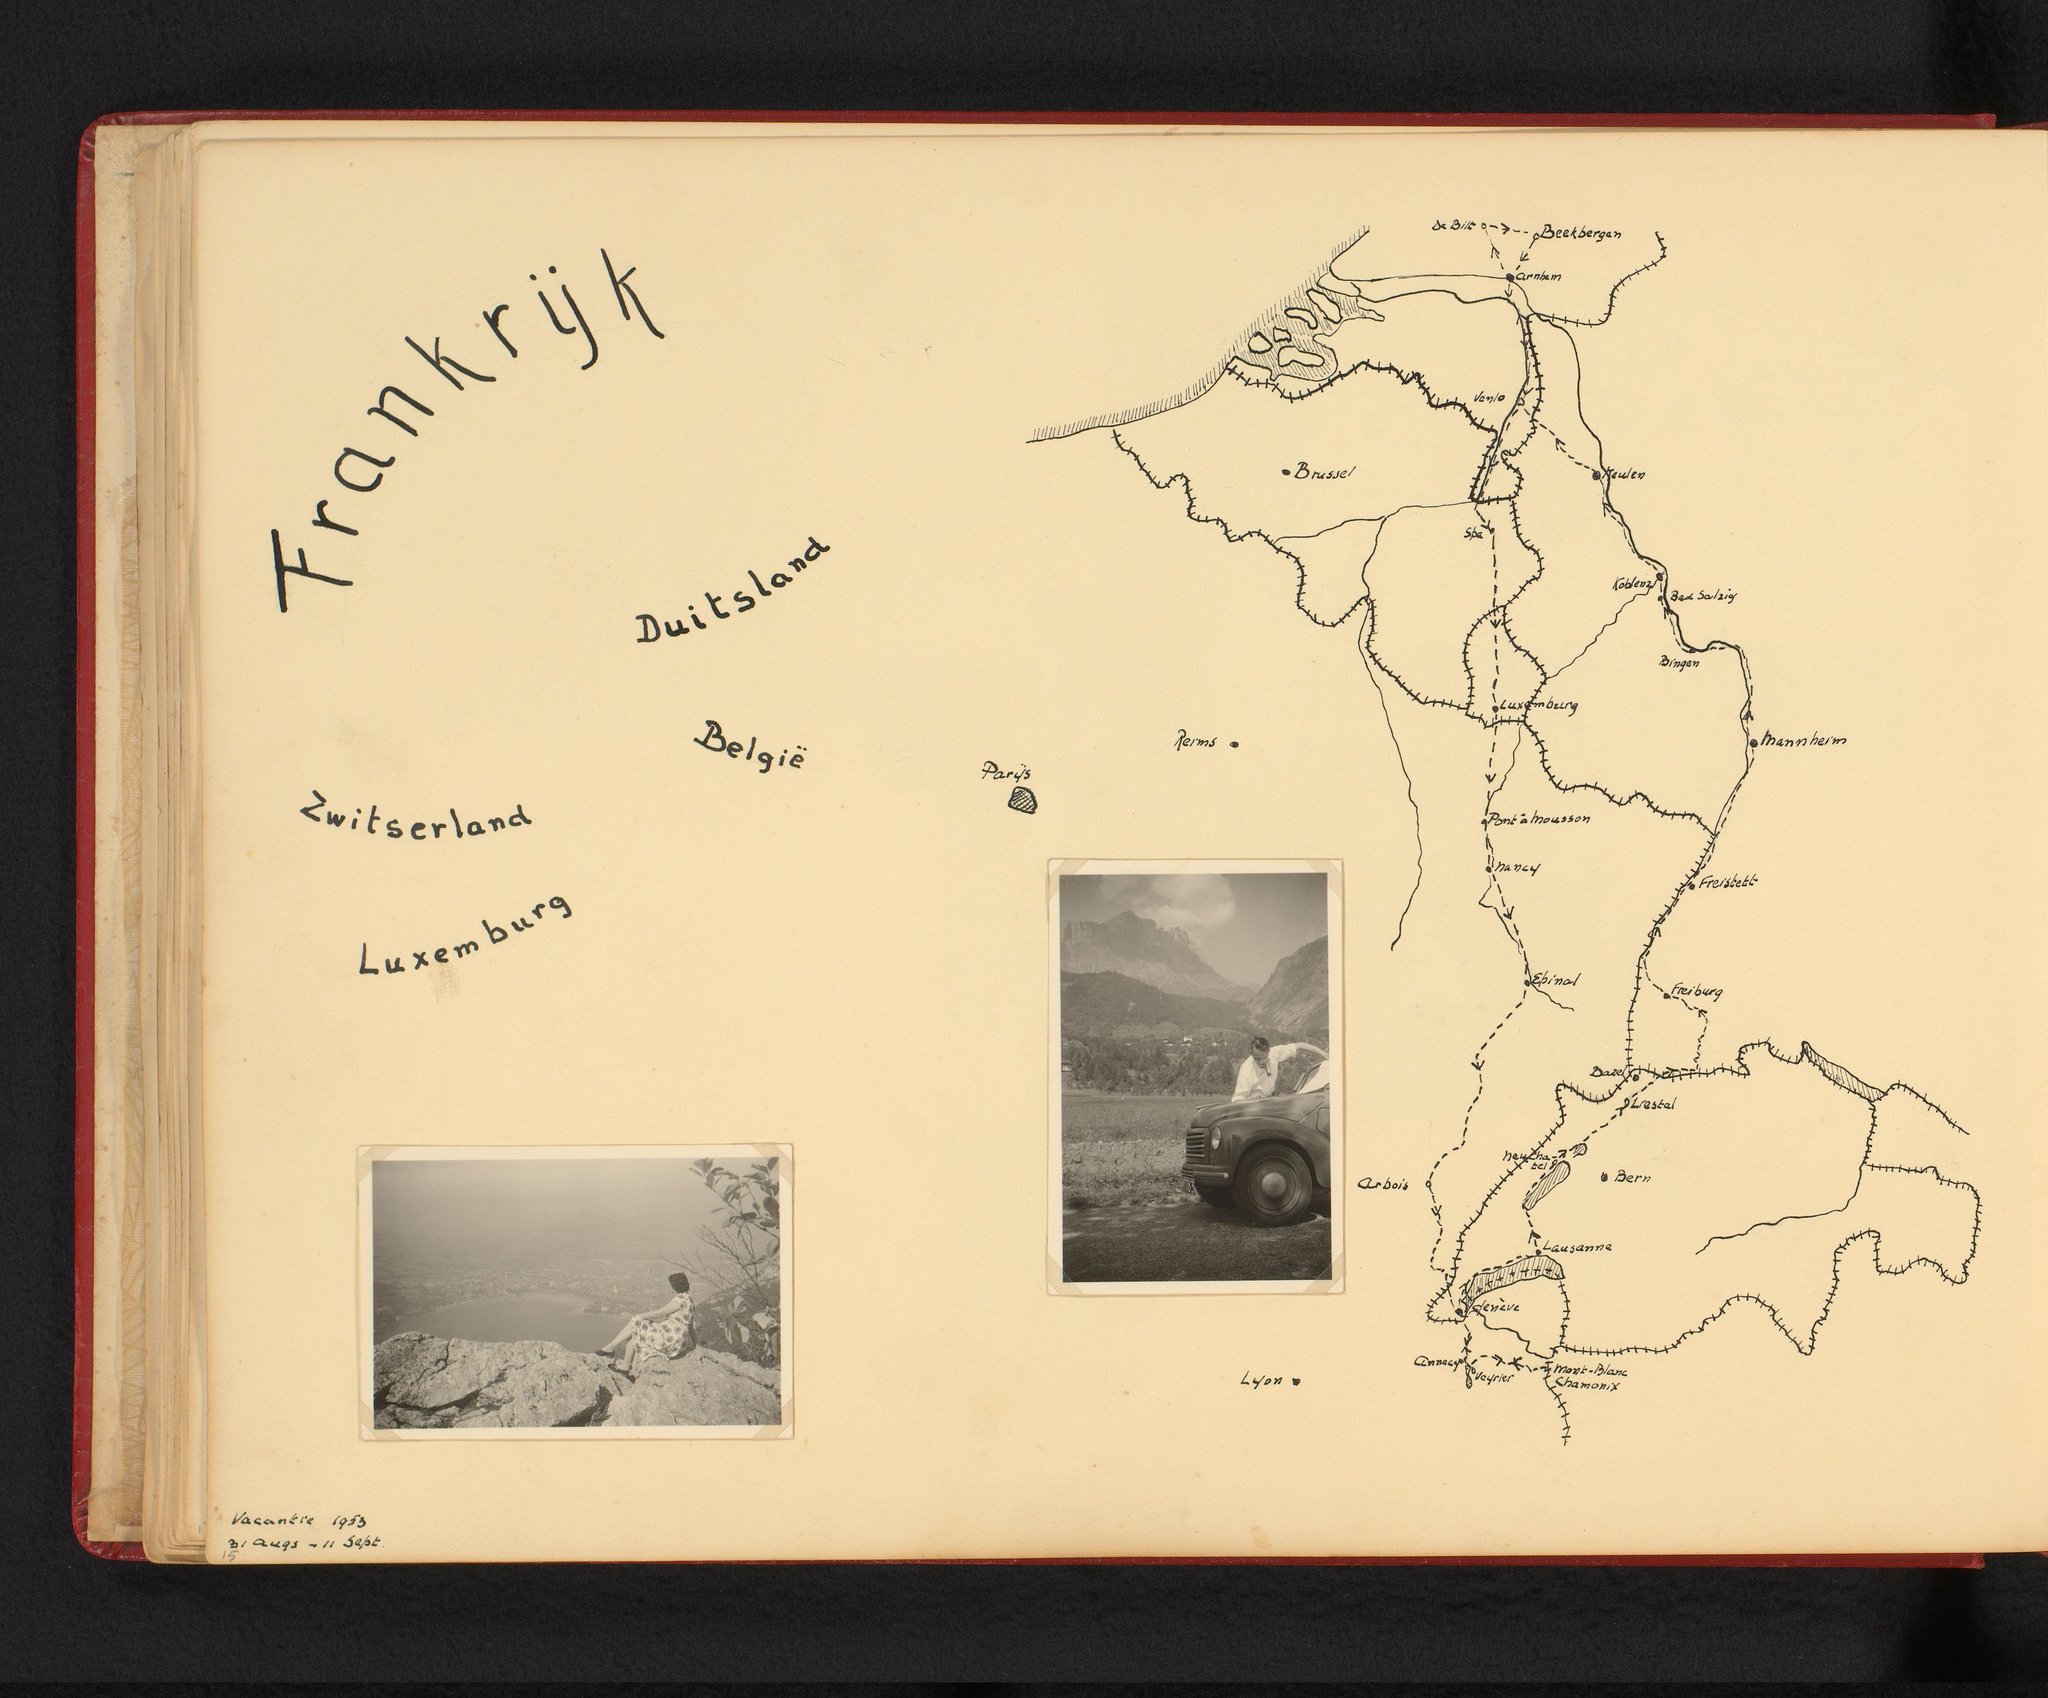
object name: photograph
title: Vakantie naar Frankrijk, België, Luxemburg, Duitsland en Zwitserland in 1953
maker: Anonymous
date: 1953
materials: ink, paper, photographic support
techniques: gelatin silver print, pen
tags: the family travelling, on holiday, maps of separate countries or regions, outing, pleasure trip, automobile, netherlands, germany, france, switzerland, belgium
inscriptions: inscription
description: Albumblad met twee foto's van de vrouw en man van wie het fotoalbum was, met hun auto, en daarnaast een getekende kaart van de route van hun reis vanaf Beekbergen naar Zwitserland en weer terug. Herinnering aan de vakantiereis van 31 augustus tot 11 september 1953. Onderdeel van het fotoalbum 'Met de Fiat 500 cabriolet op vakantie' met foto's van vakanties van een gezin tussen 1951-1959.